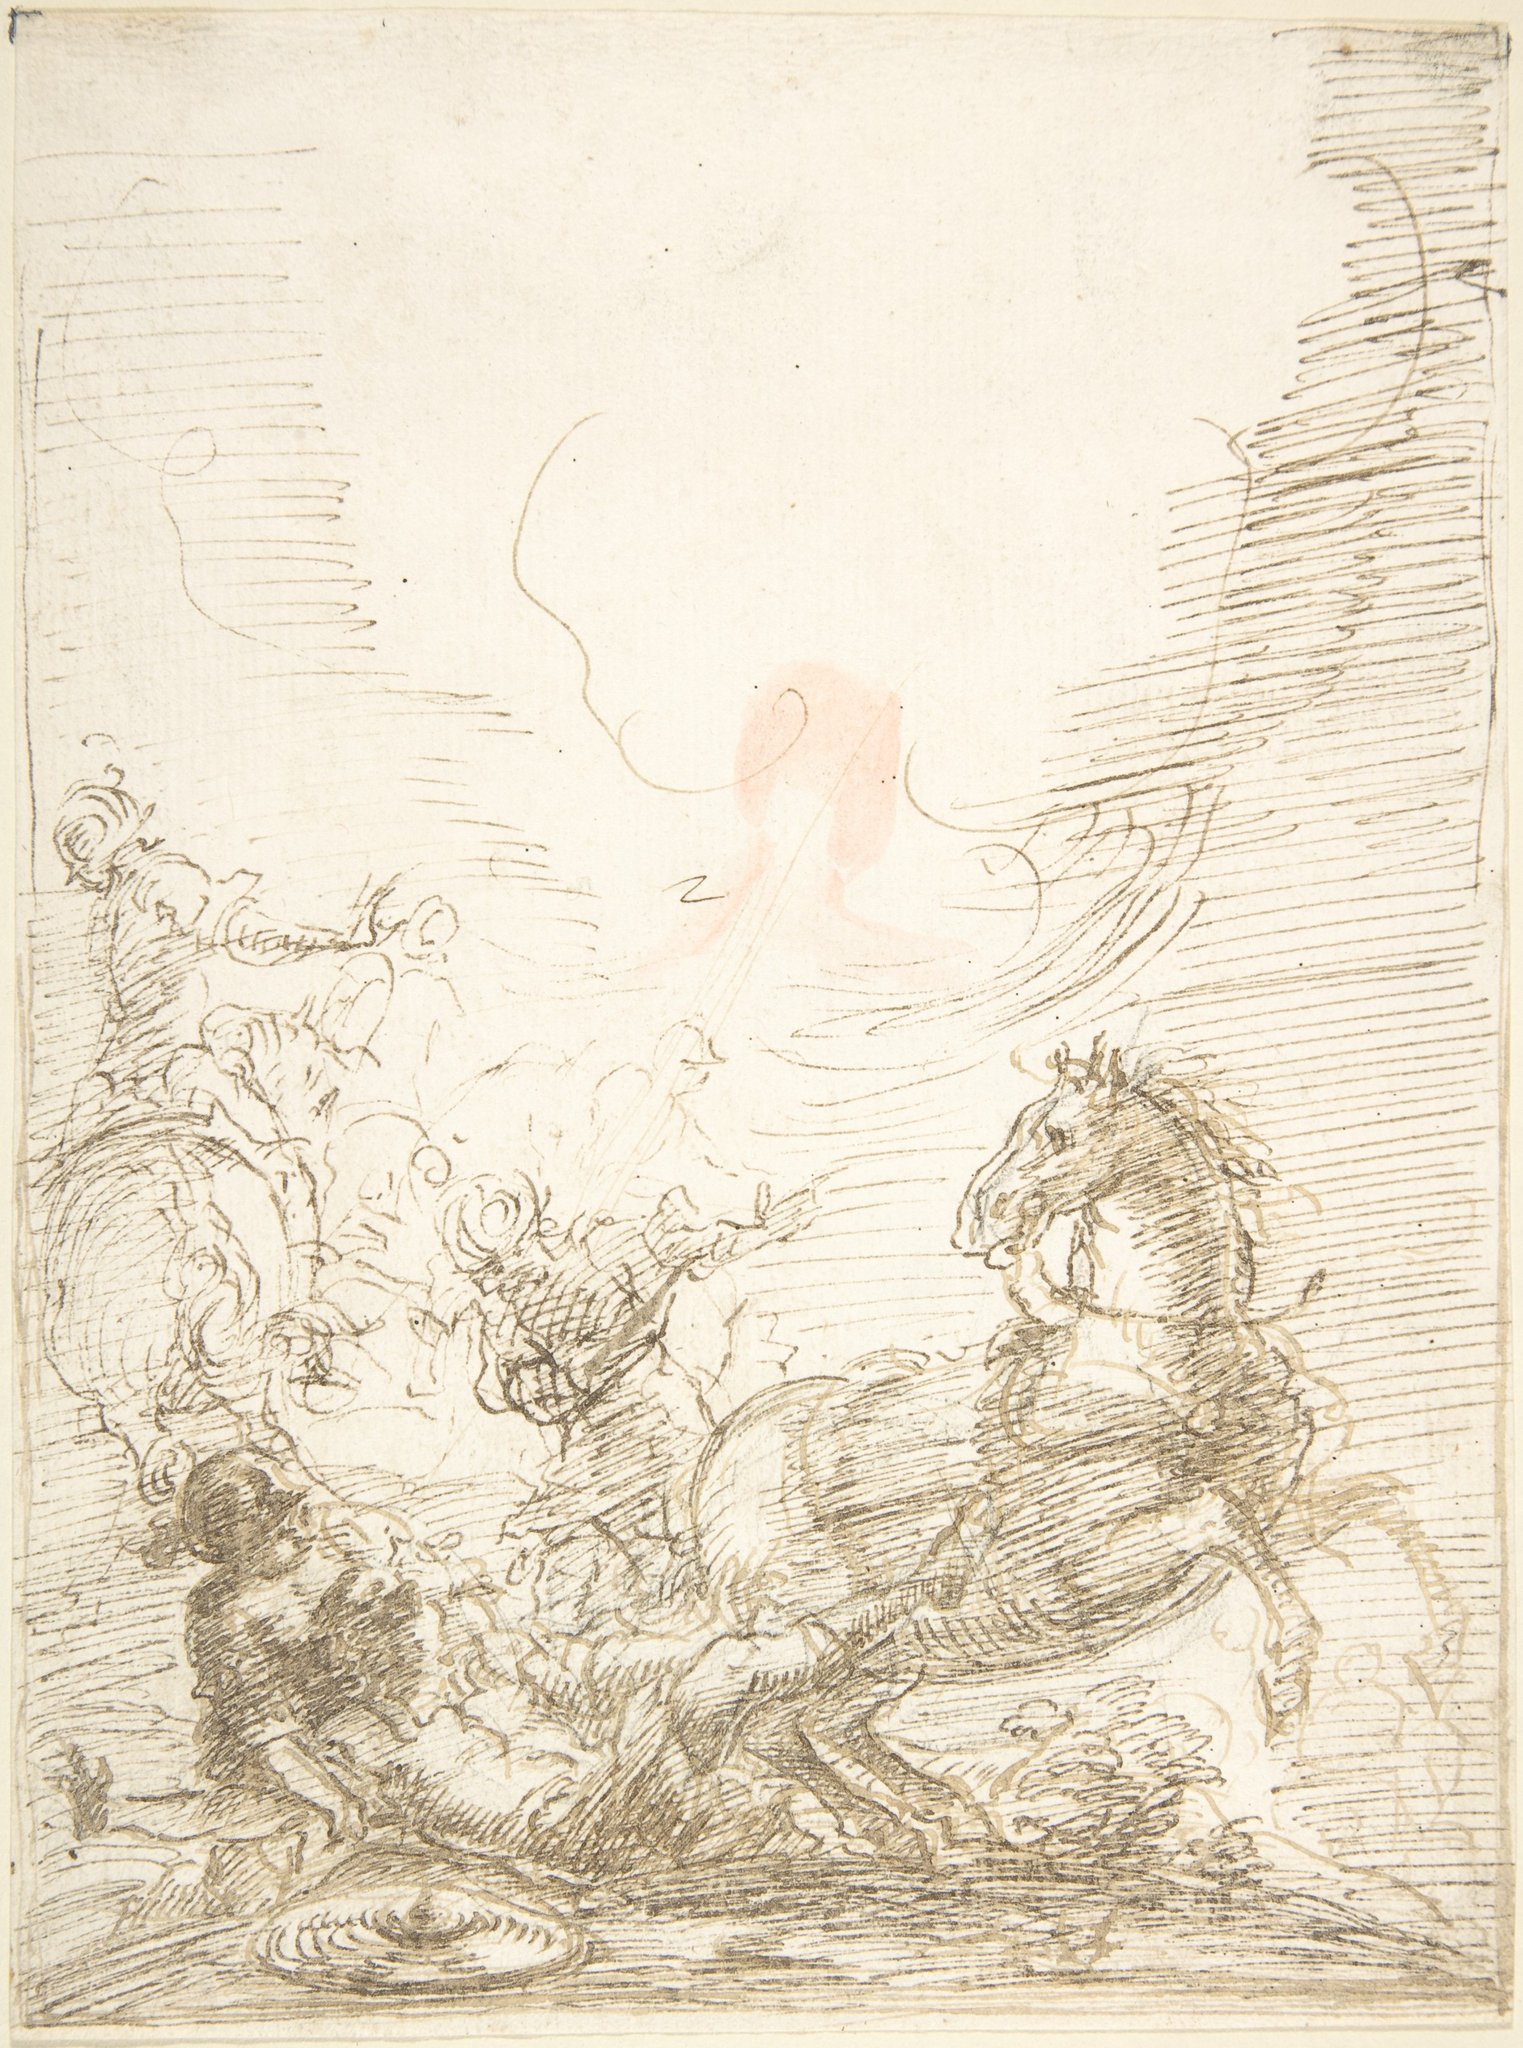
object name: drawing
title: The Conversion of Saint Paul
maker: anonymous, spanish, school of seville, 17th century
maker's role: artist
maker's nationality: spanish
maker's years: 1600-1700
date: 1601-1700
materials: chalk, ink, paper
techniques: brush, pen, drawing, wash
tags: girls,horses,saint paul